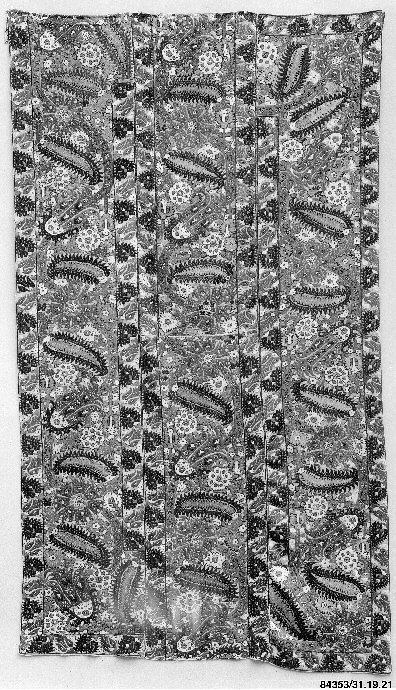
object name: hanging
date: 1701-1800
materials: cotton, silk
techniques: embroidery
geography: greece